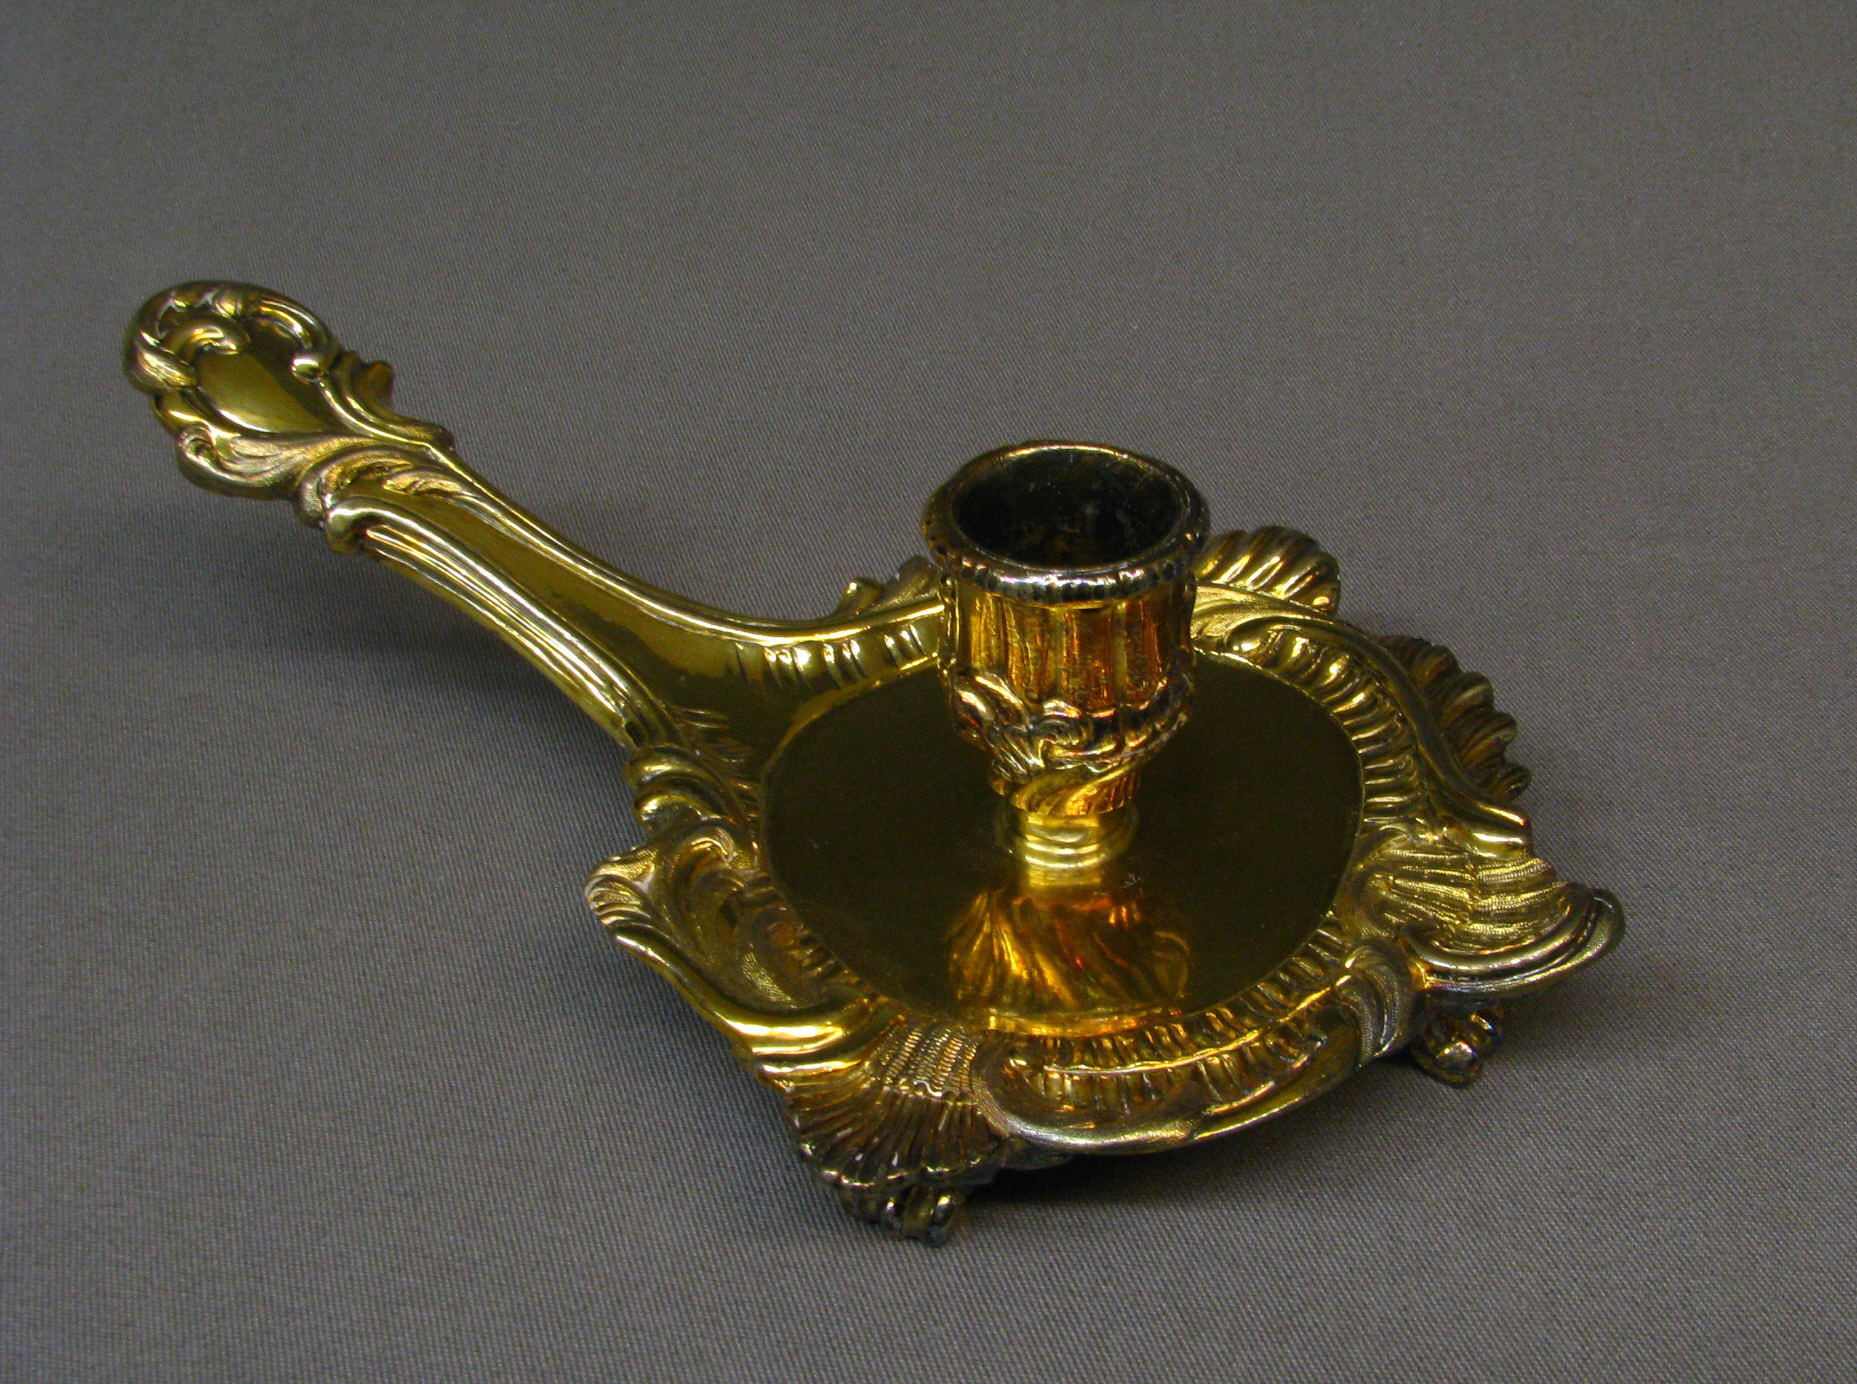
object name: chamber candlestick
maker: robert hennell i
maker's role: maker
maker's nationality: british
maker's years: 1741-1811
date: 1810-1811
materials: silver gilt